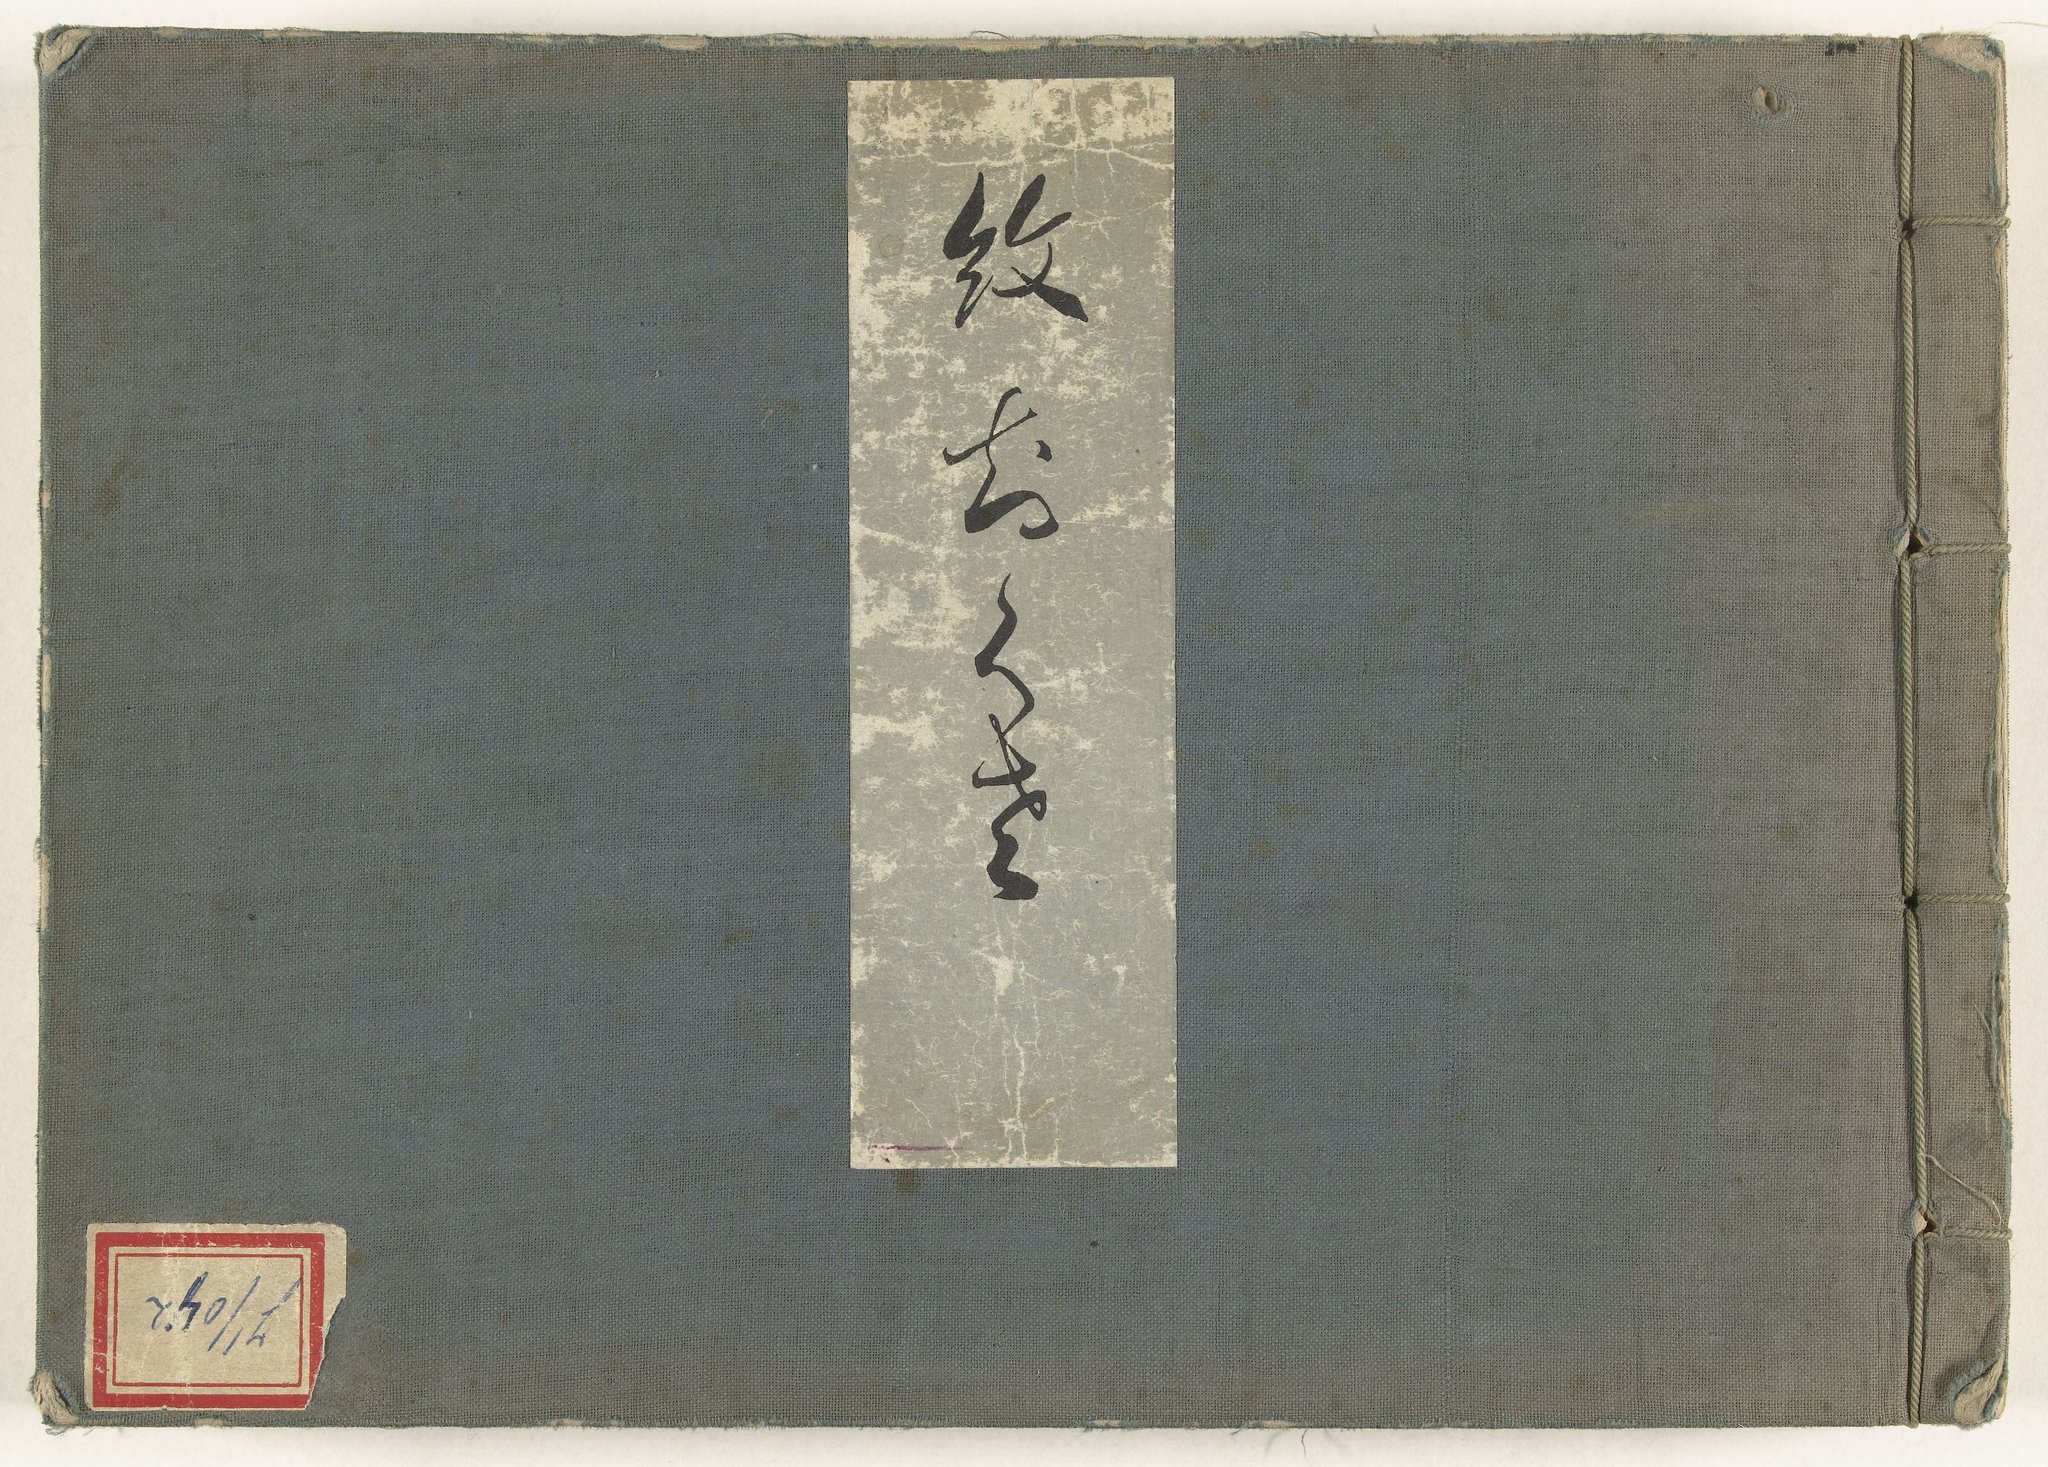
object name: book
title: Japanse familiewapens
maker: Anonymous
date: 1913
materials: paper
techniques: woodcut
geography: tokyo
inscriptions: collector's mark: Lugt 2228, collector's mark: ‘Economisch-historische bibliotheek Amsterdam’